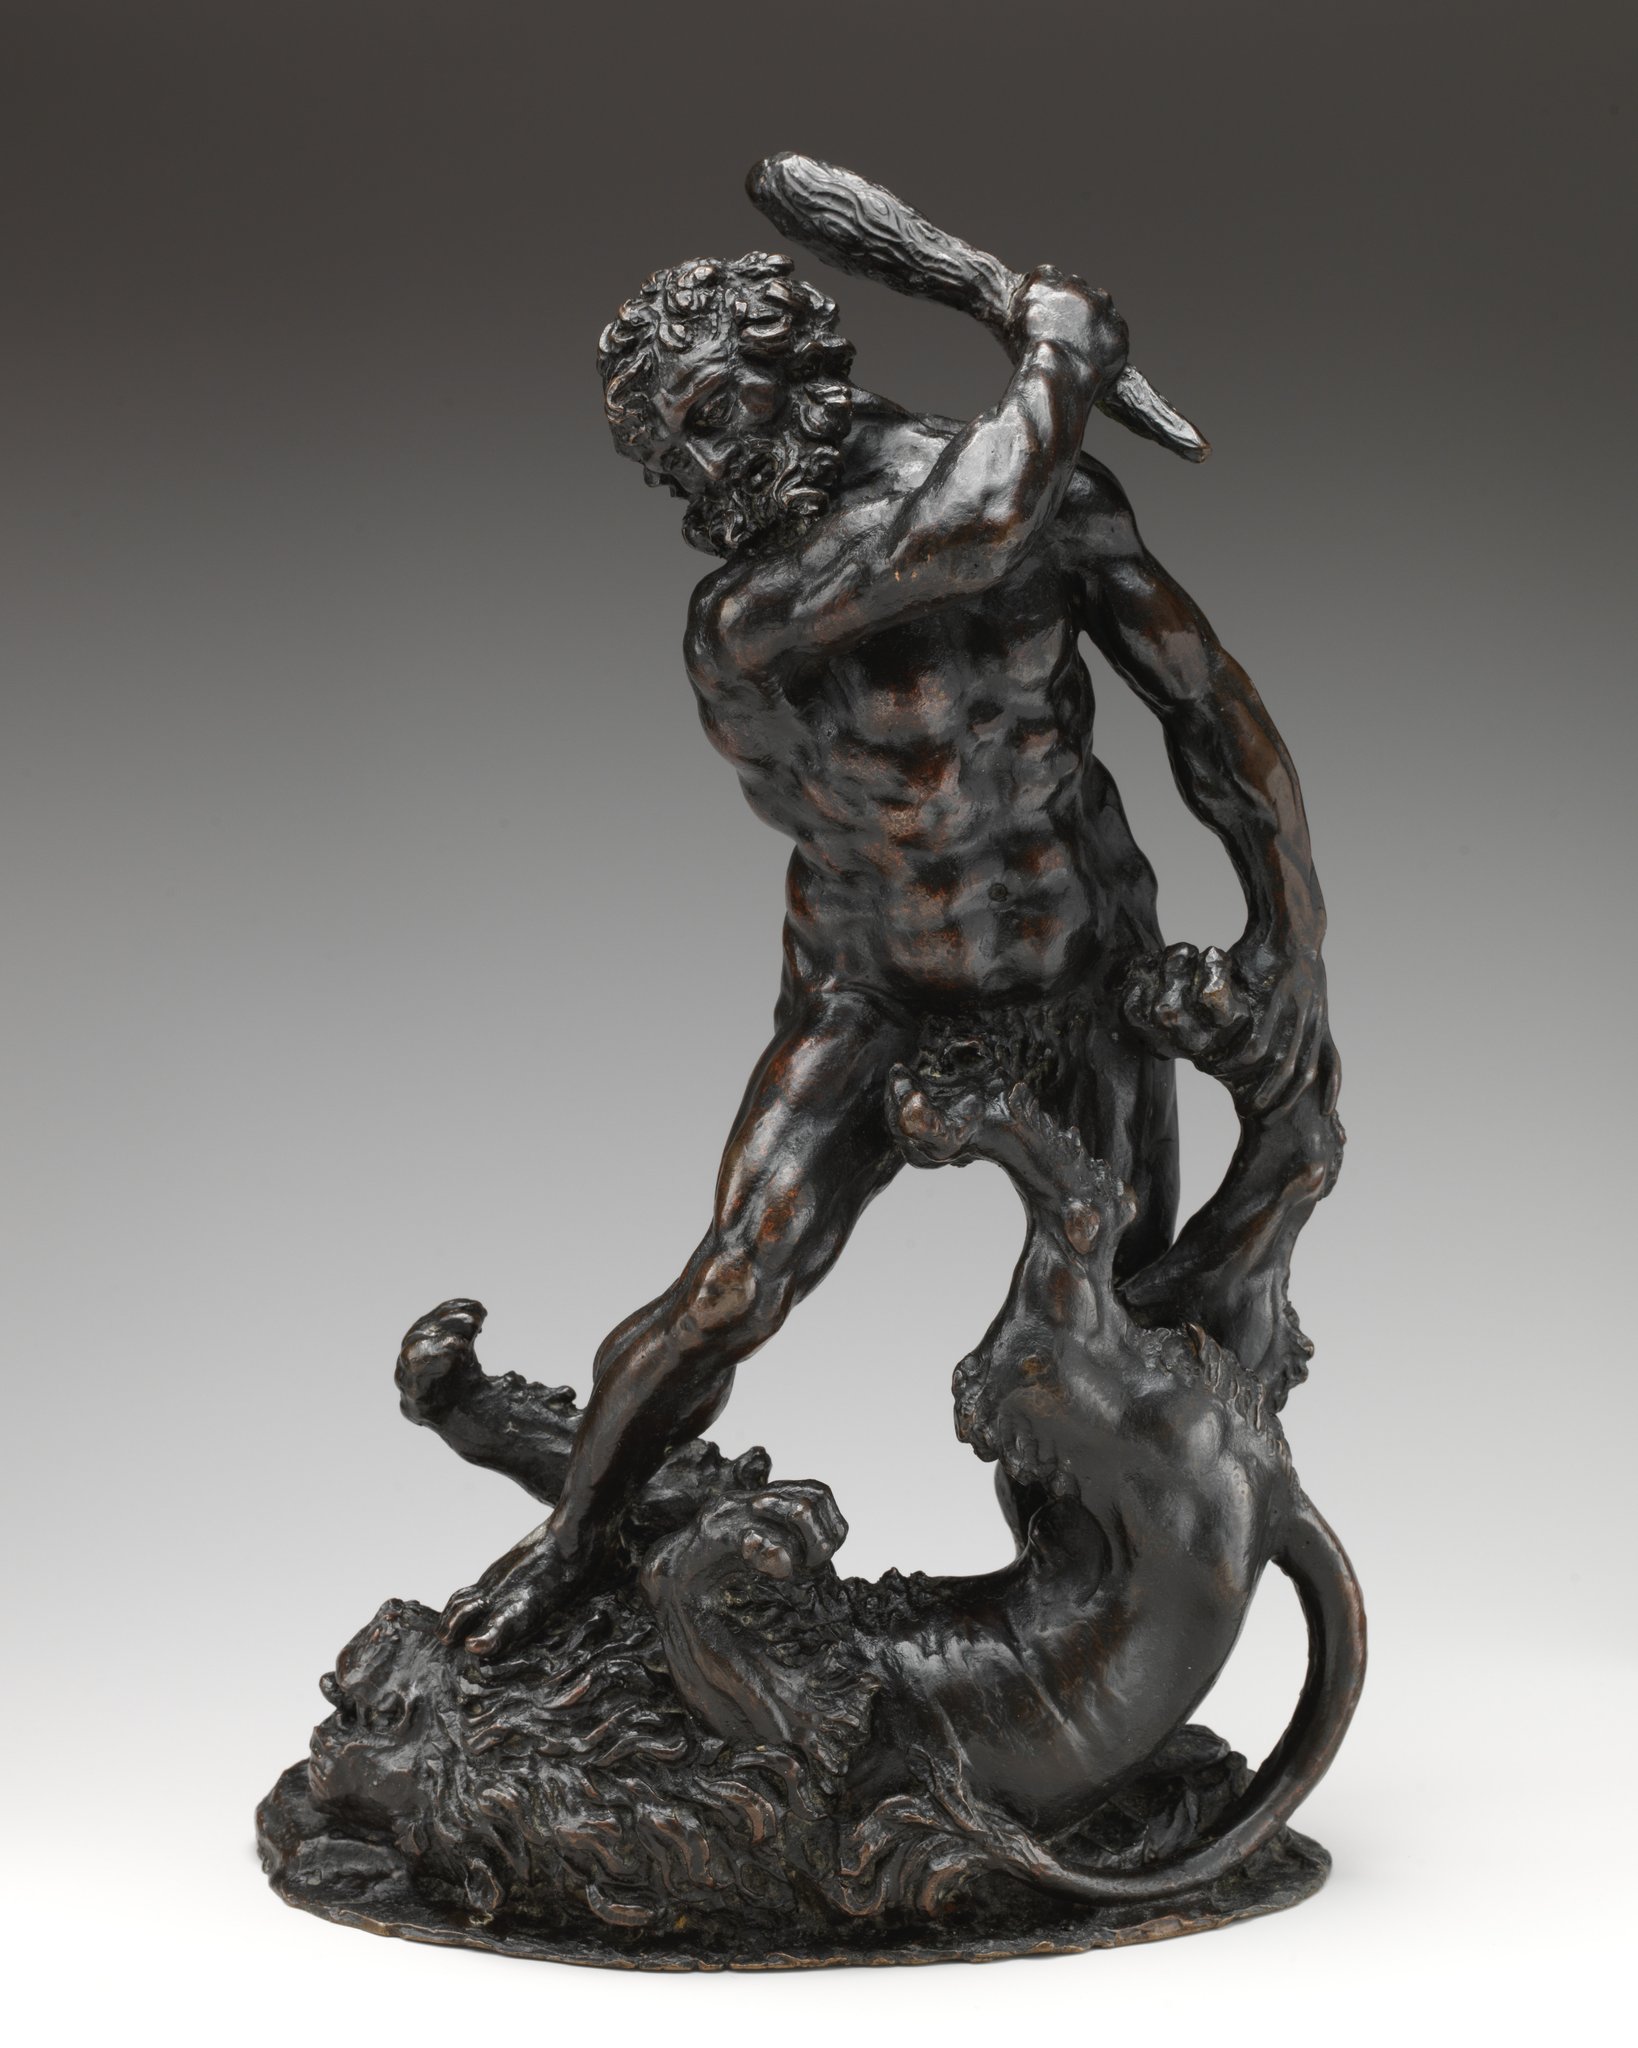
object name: statuette group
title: Hercules and the Nemean Lion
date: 1667-1700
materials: bronze, lacquer, patina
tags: hercules,lions